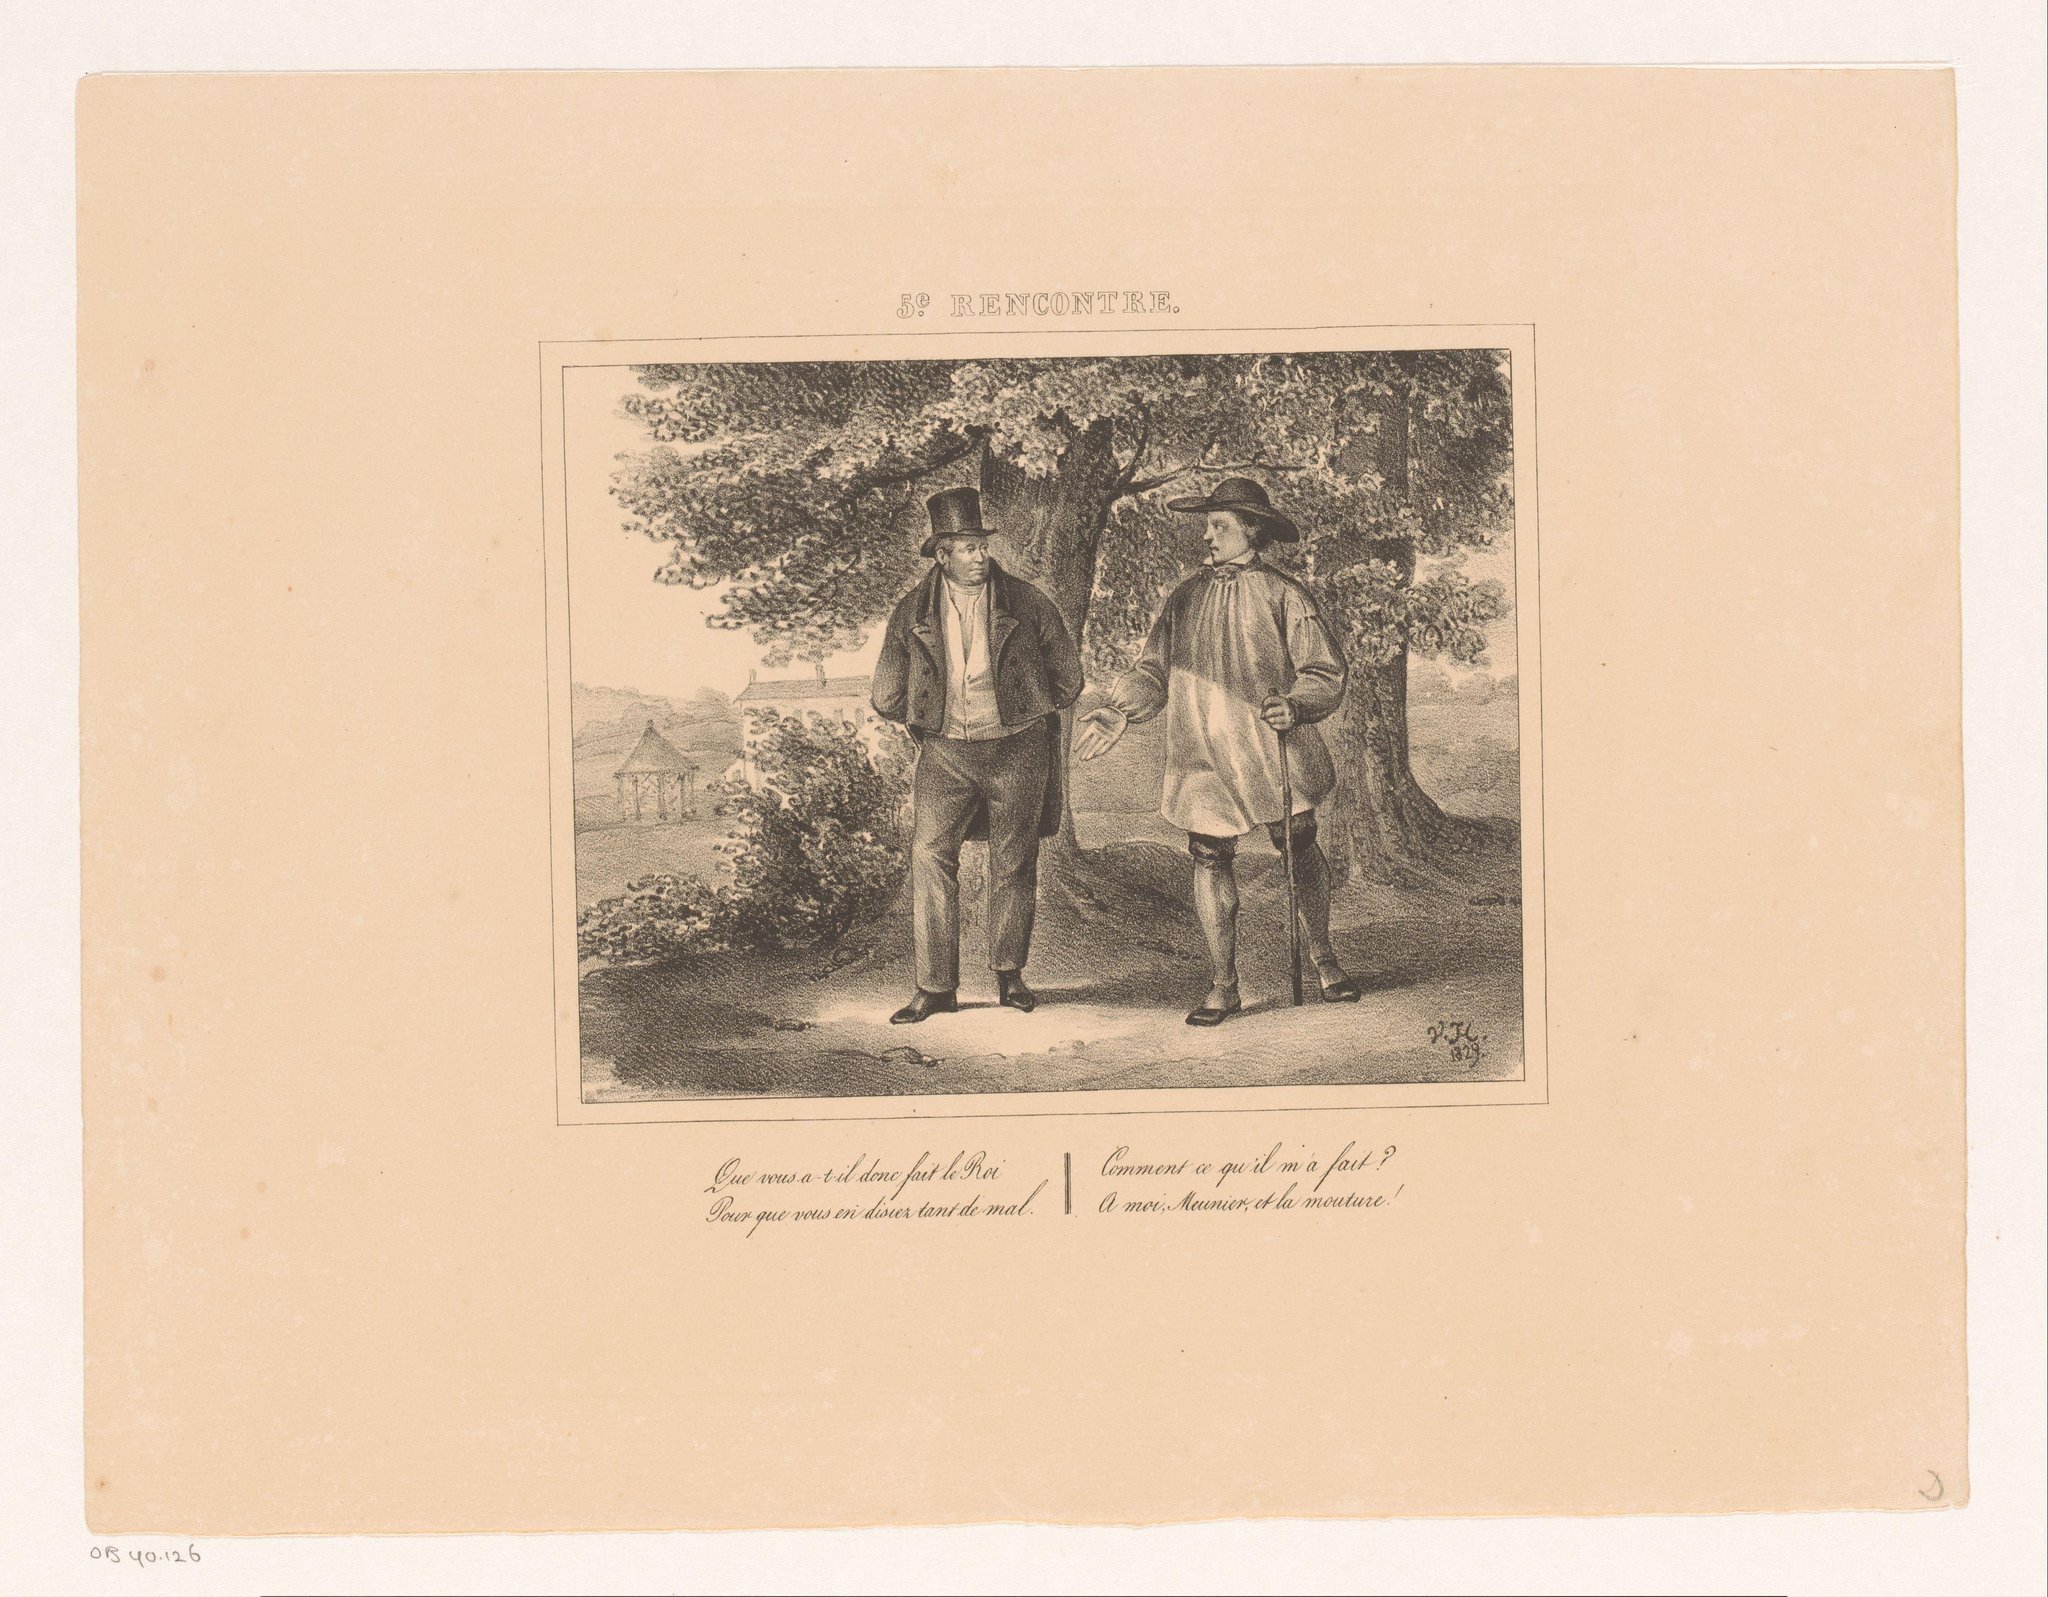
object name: print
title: Koning Willem I spreekt met een molenaar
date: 1829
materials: paper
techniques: lithograph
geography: brussels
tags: the hague, berlin, william i of the netherlands, miller, ruler in informal contact with his subjects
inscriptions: collector's mark: Lugt 2228